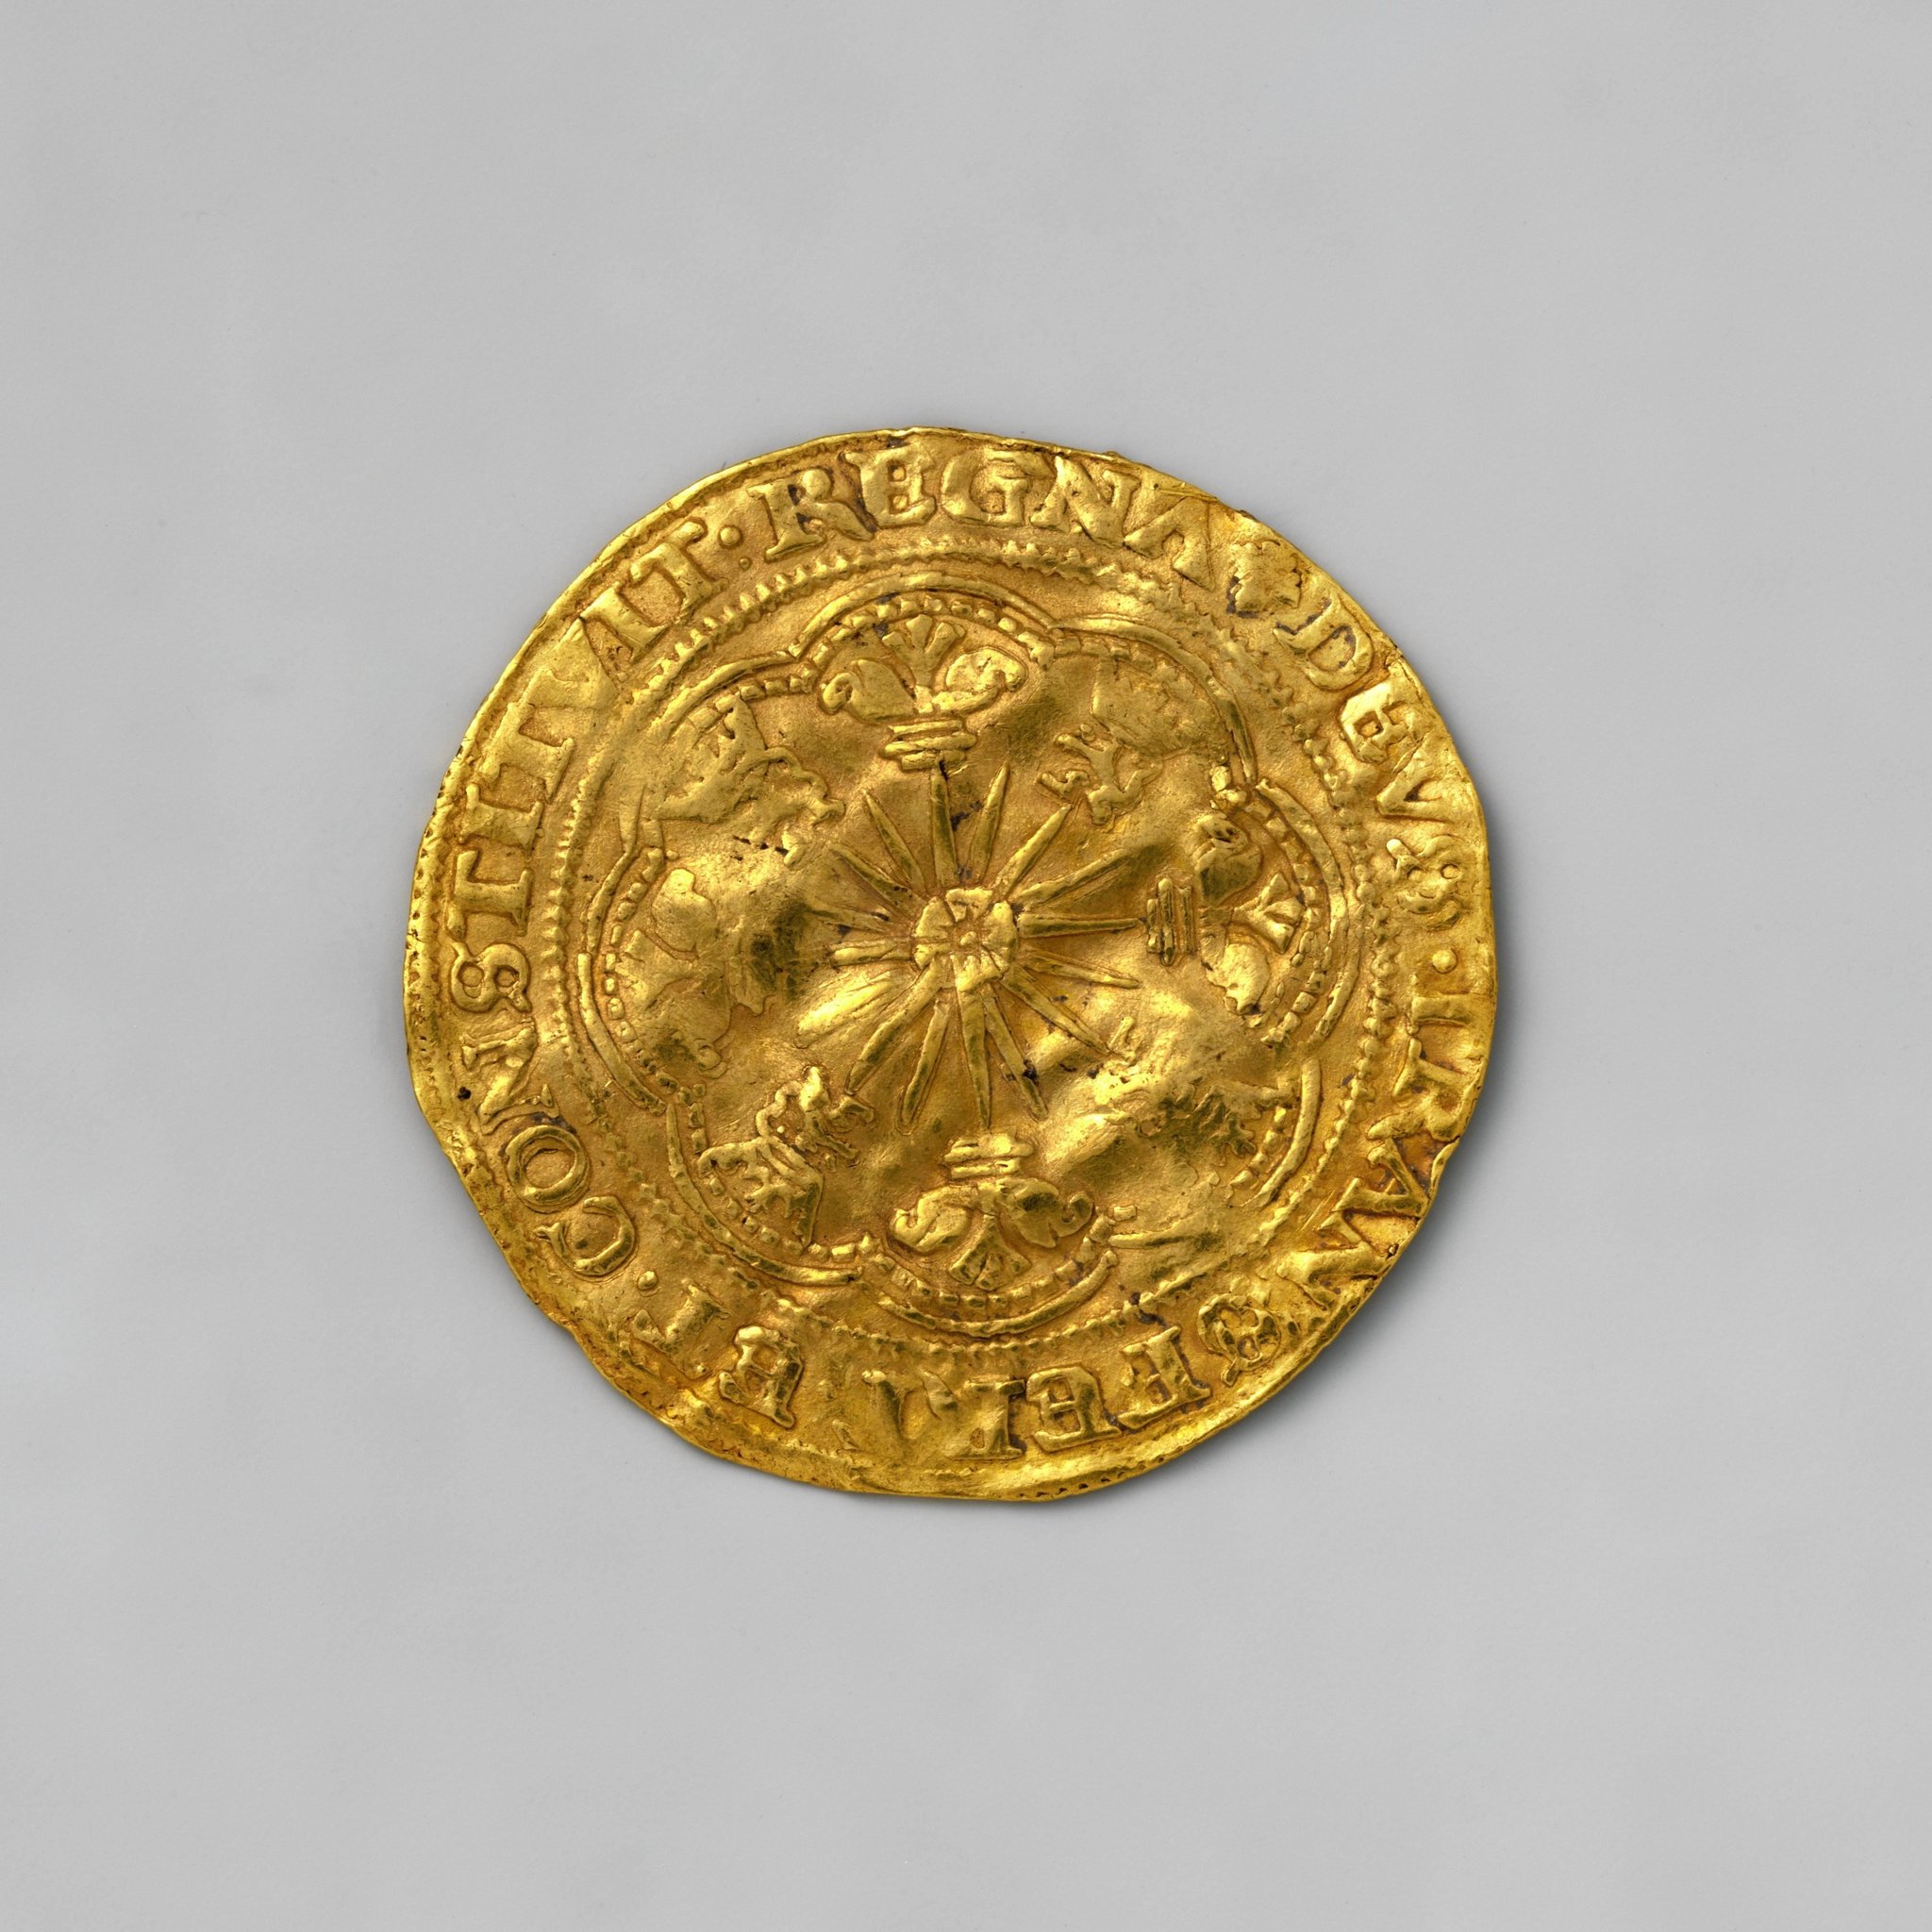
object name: rozenobel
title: Gelderland, rozenobel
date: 1583-1584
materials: gold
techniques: striking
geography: harderwijk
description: Voorzijde: gekroonde staande vorst met zwaard in schip met voor zich Gelders wapenschild, op scheepsromp roos. Keerzijde: in veelpas gebloemd kruis met in het hart roos, waaruit zonnestralen, in de hoeken leeuwen met kroon. Begin van omschrift: DEVS TRANSFERT ..